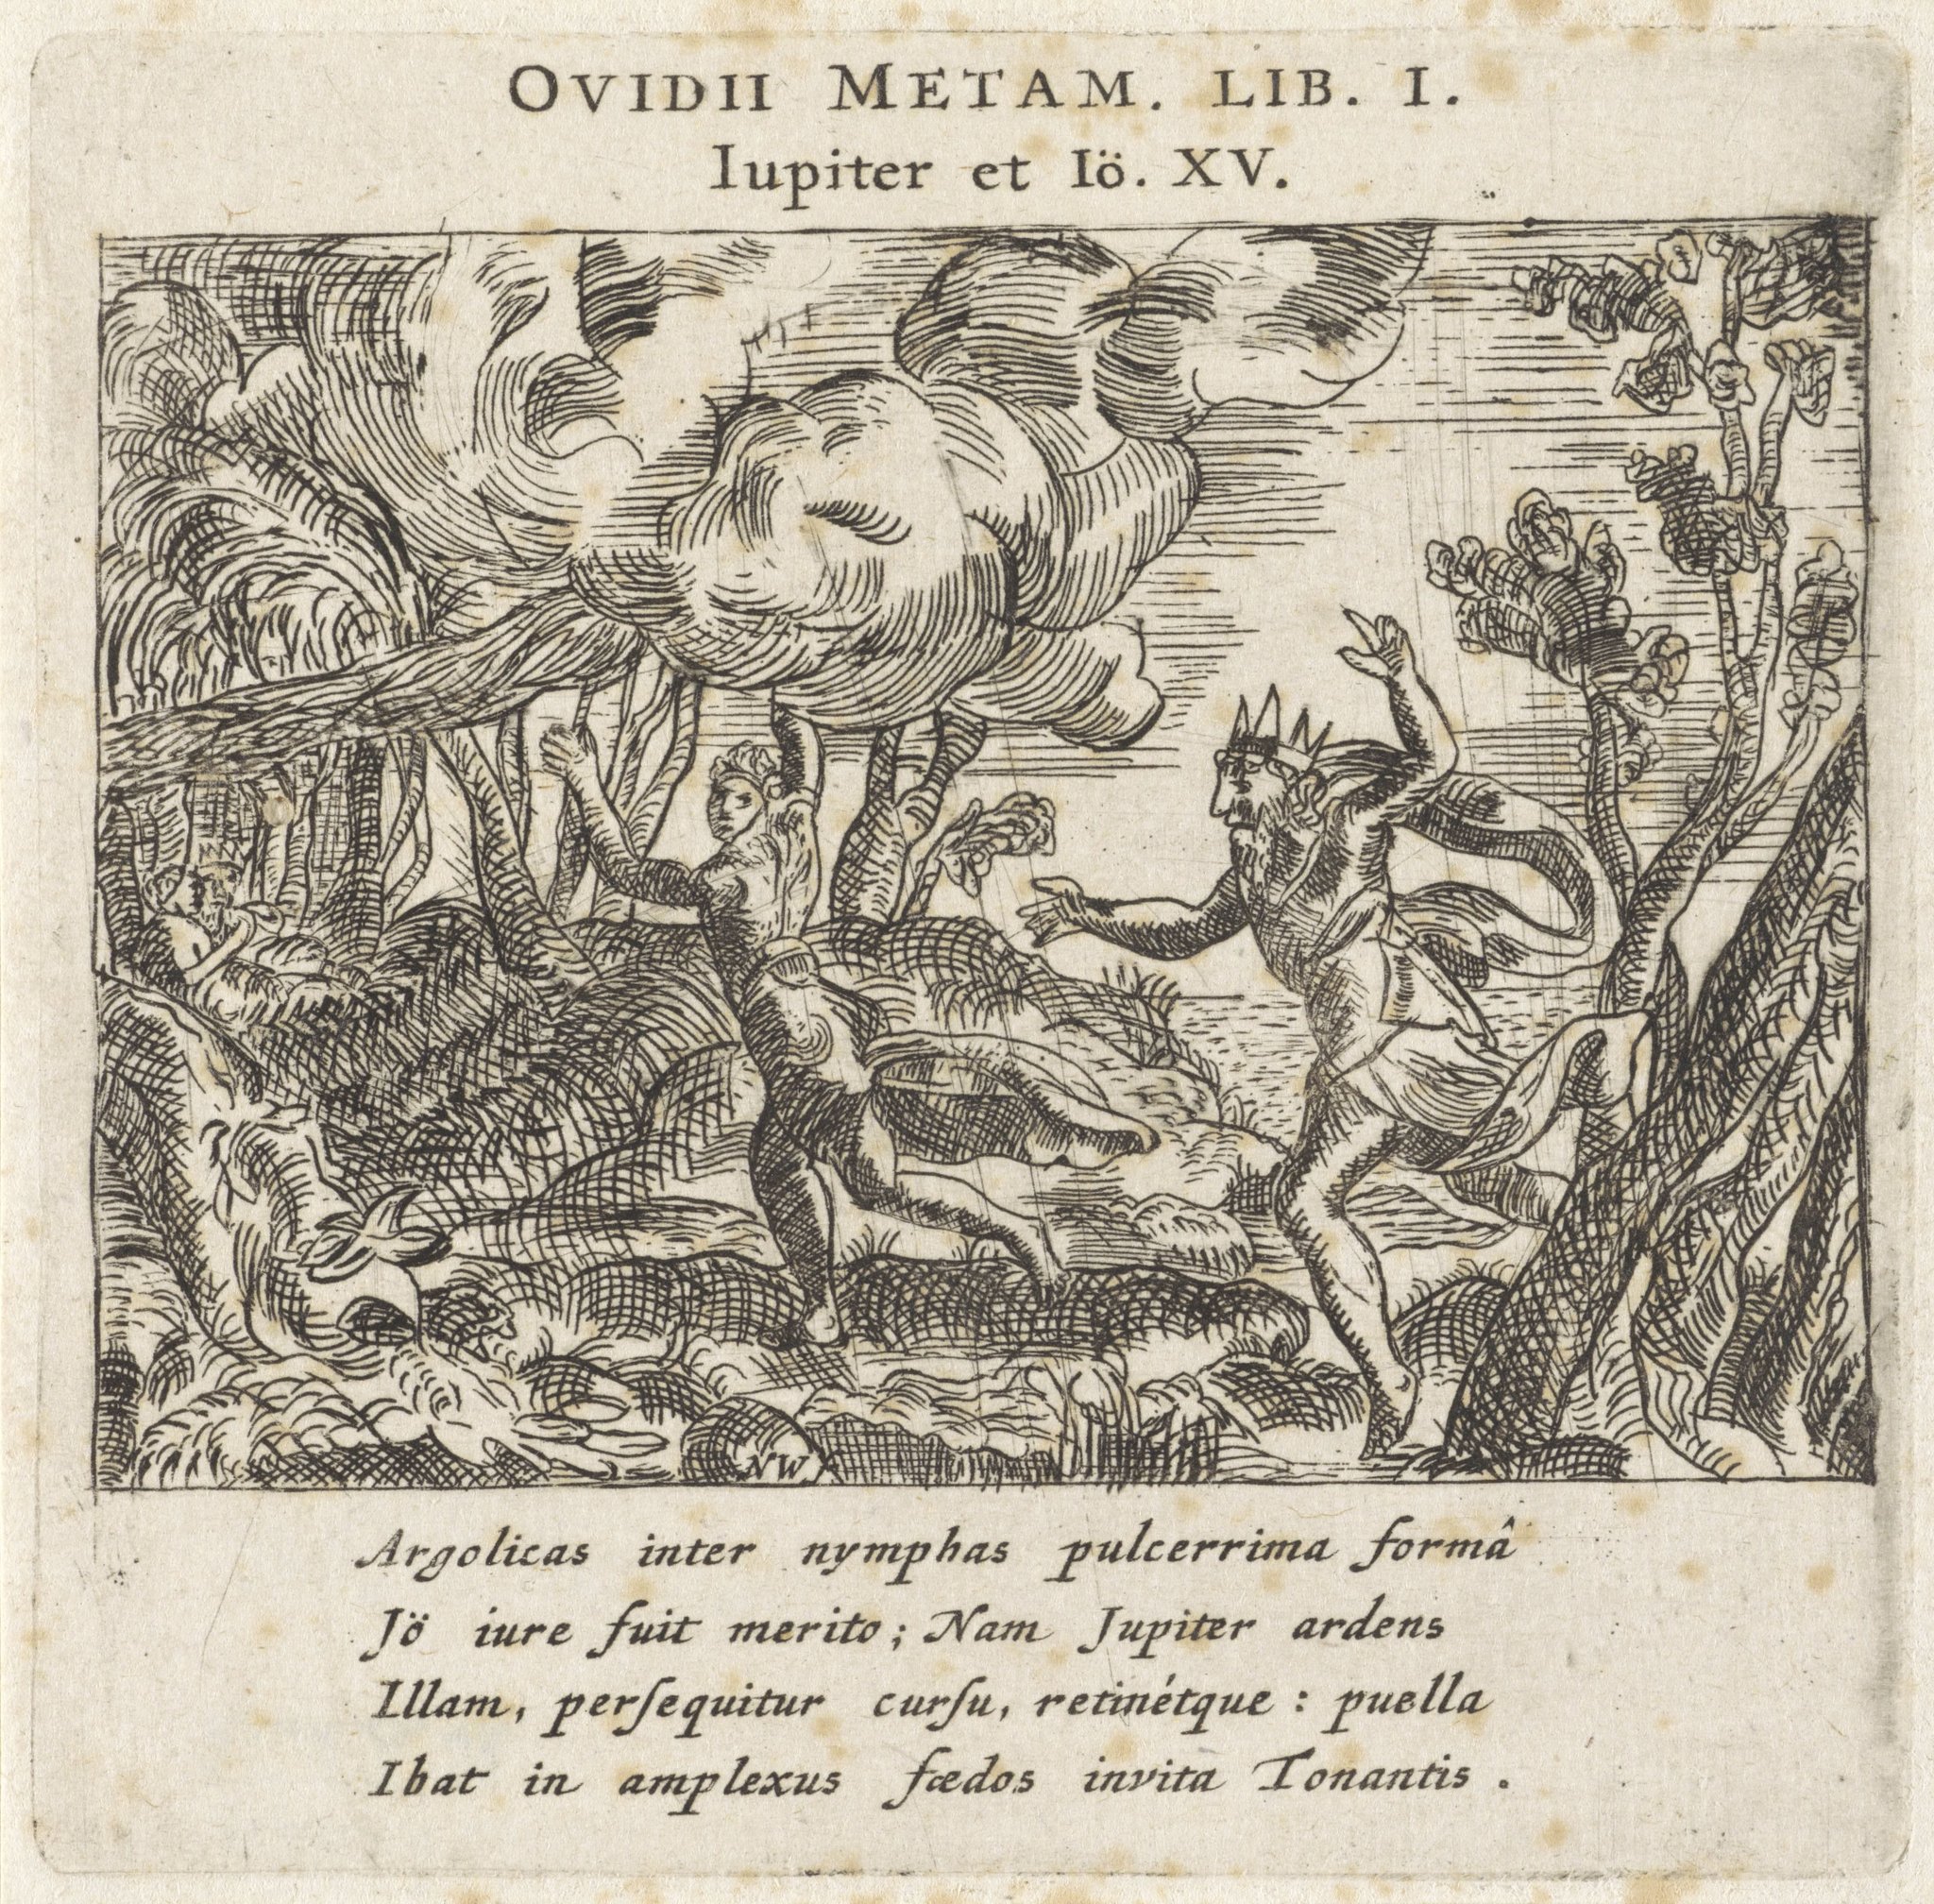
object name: print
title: Ovidii Metam. Lib. I Iupiter et Iö XV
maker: nicolaes cornelisz. witsen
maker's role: mayor, print maker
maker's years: 1641-1717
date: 1659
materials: paper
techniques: etching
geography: amsterdam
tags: io changed into a cow: to avoid detection by juno, jupiter changes io into a cow (ovid, metamorphoses i 611) (+ variant)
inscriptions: collector's mark: Lugt 2165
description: Jupiter achtervolgt Io door het bos, Onder de voorstelling een vierregelige toelichting in het Latijn.